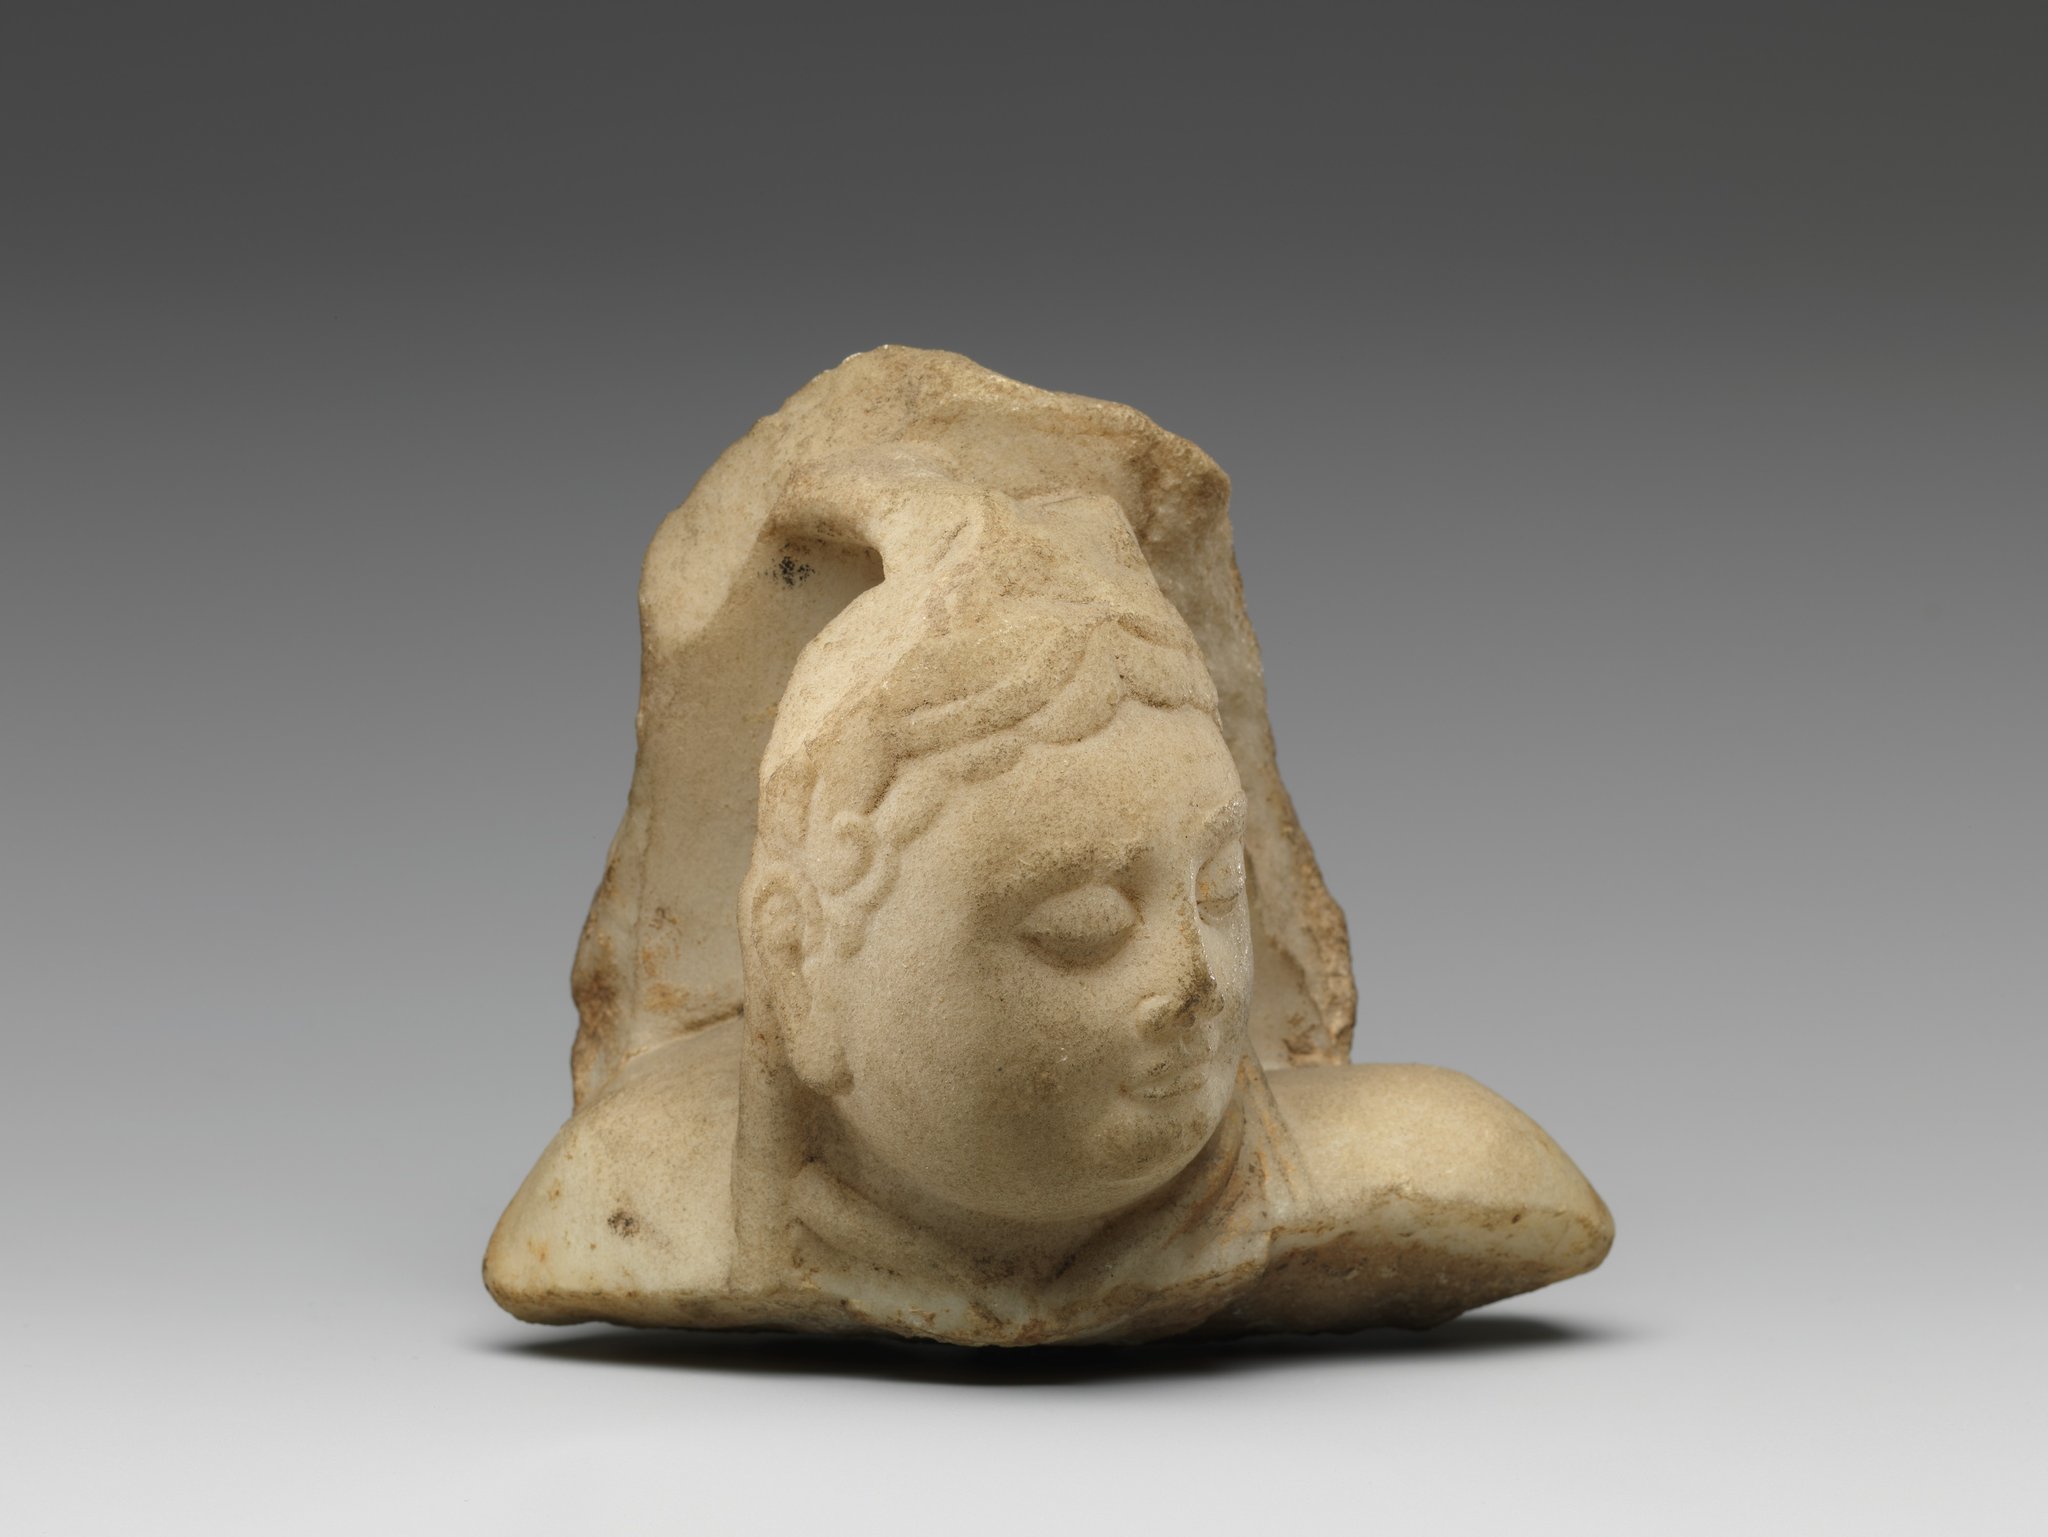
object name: head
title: Head of a Bodhisattva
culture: chinese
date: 901-1000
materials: marble, pigment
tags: heads,buddhism,bodhisattvas